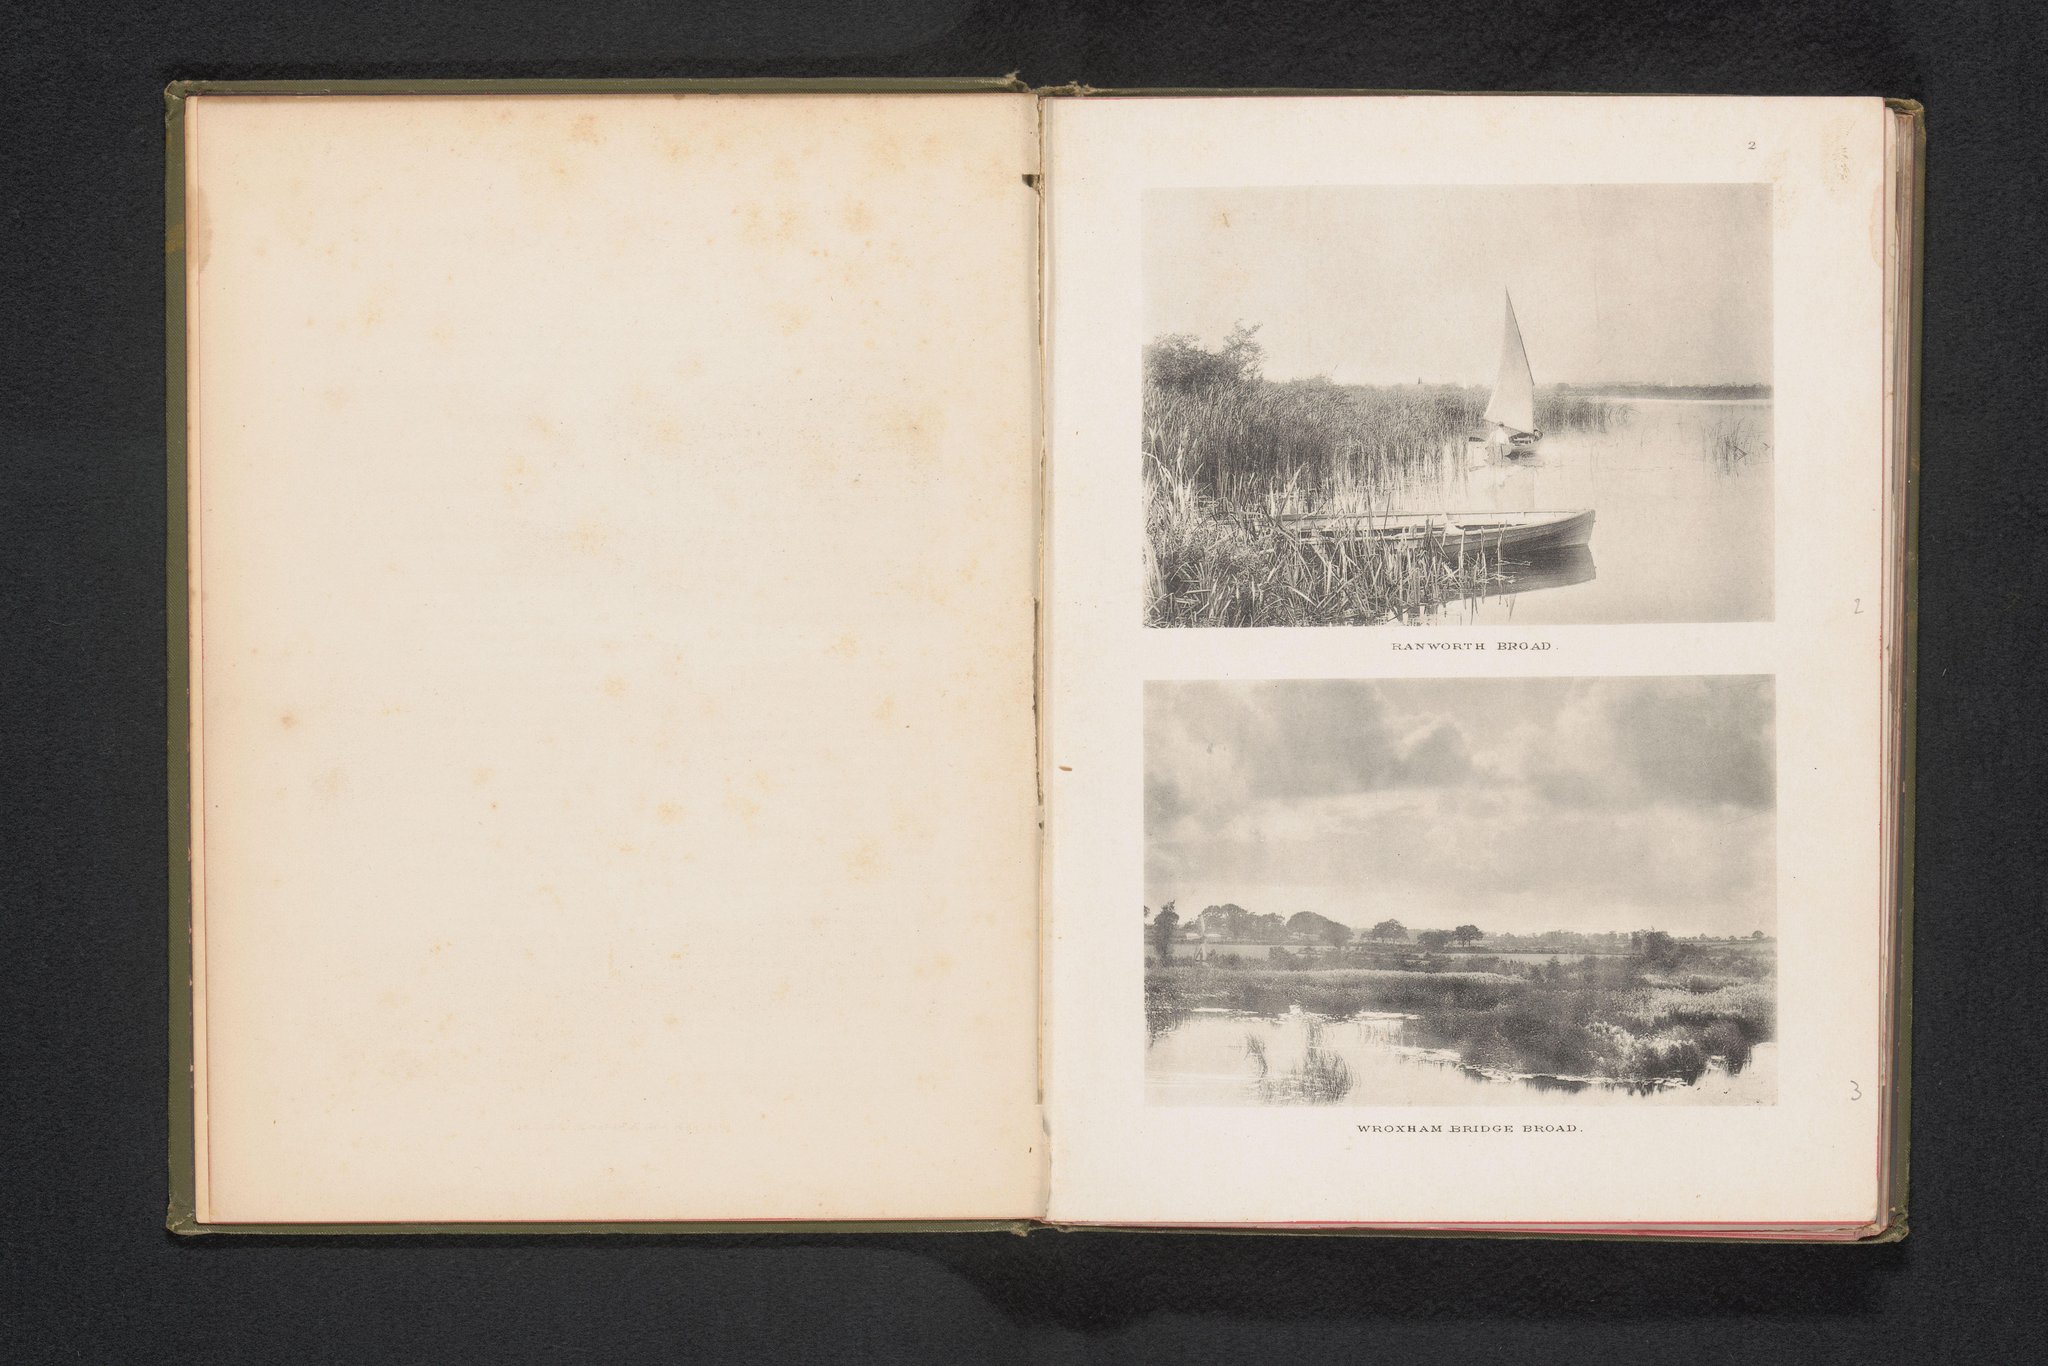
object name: page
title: Wroxham Bridge Broad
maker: john payne jennings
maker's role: fotograaf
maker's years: 1843-1926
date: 1886-1891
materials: paper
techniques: photograph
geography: surrey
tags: landscapes, landscapes with waters, waterscapes, seascapes (in the temperate zone), windmill in landscape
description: Prent op vijfde ongenummerde pagina na titelpagina.